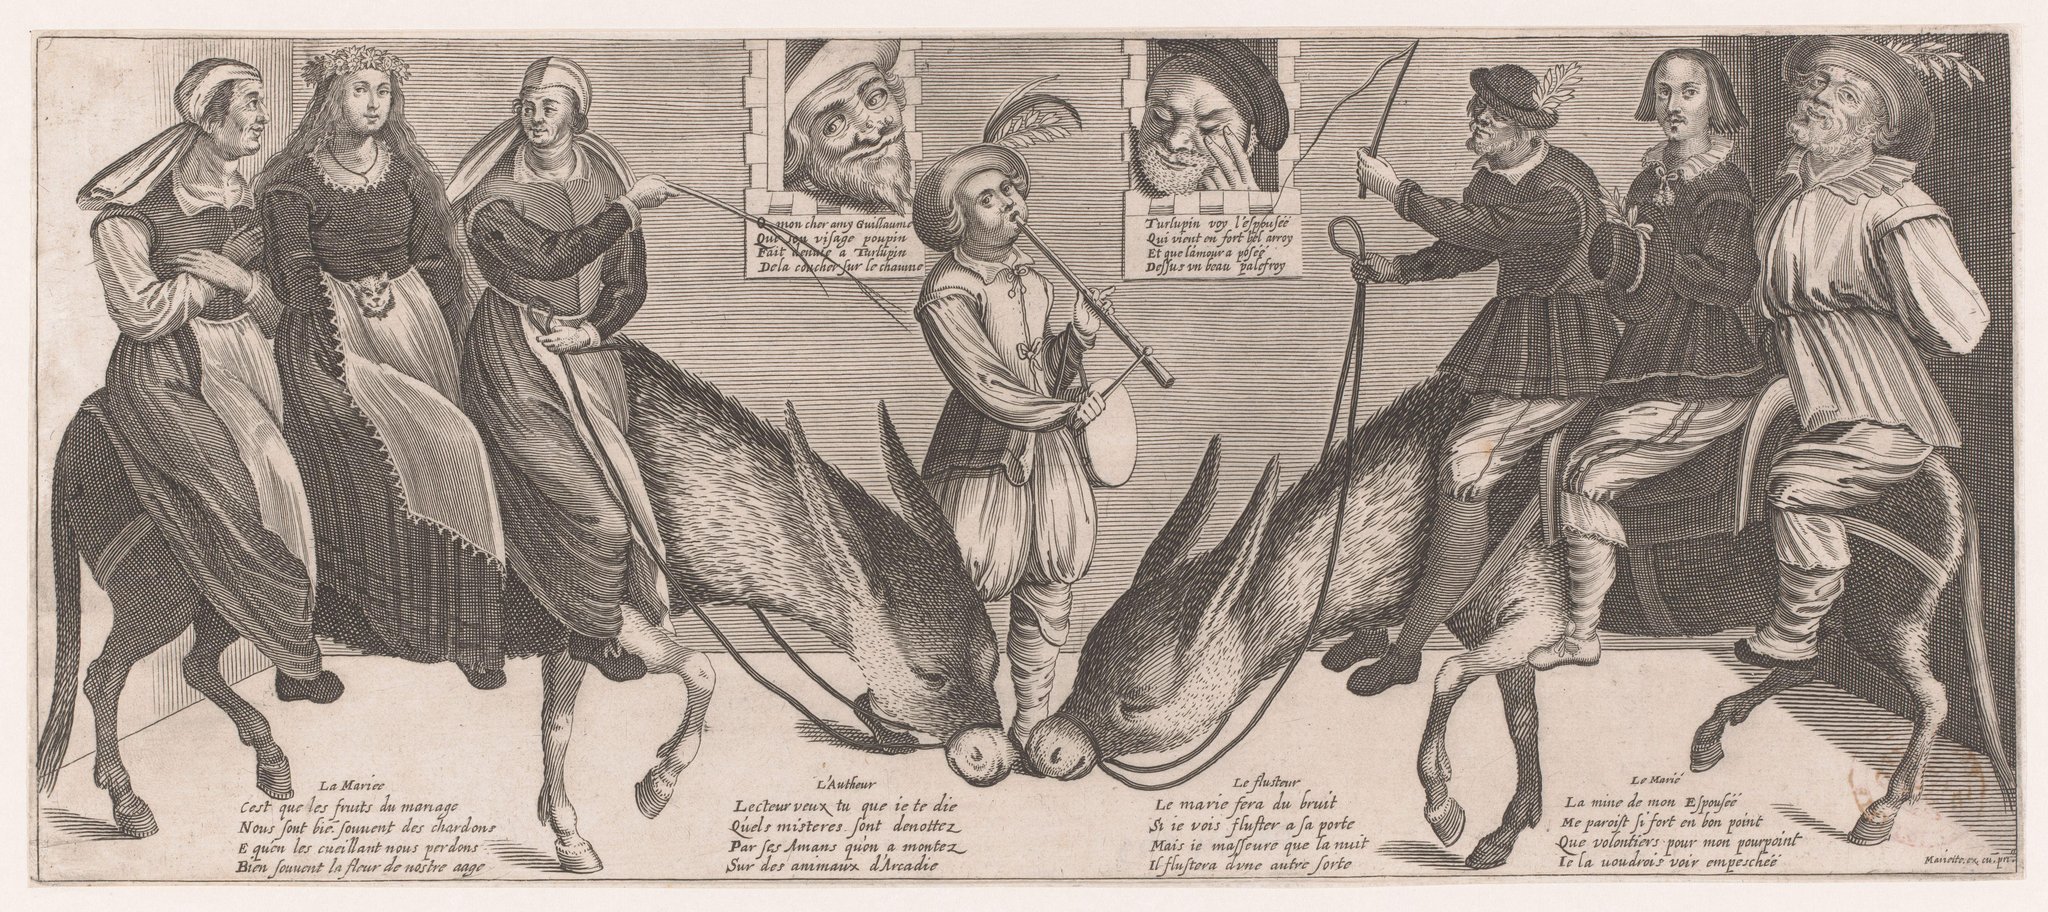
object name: print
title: Bruid en bruidegom bij elkaar gebracht op ezels, muzikant in het midden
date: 1600-1650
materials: paper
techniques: engraving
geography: france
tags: arrival of bride and bridegroom at the wedding feast, ass, donkey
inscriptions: collector's mark: Lugt 240